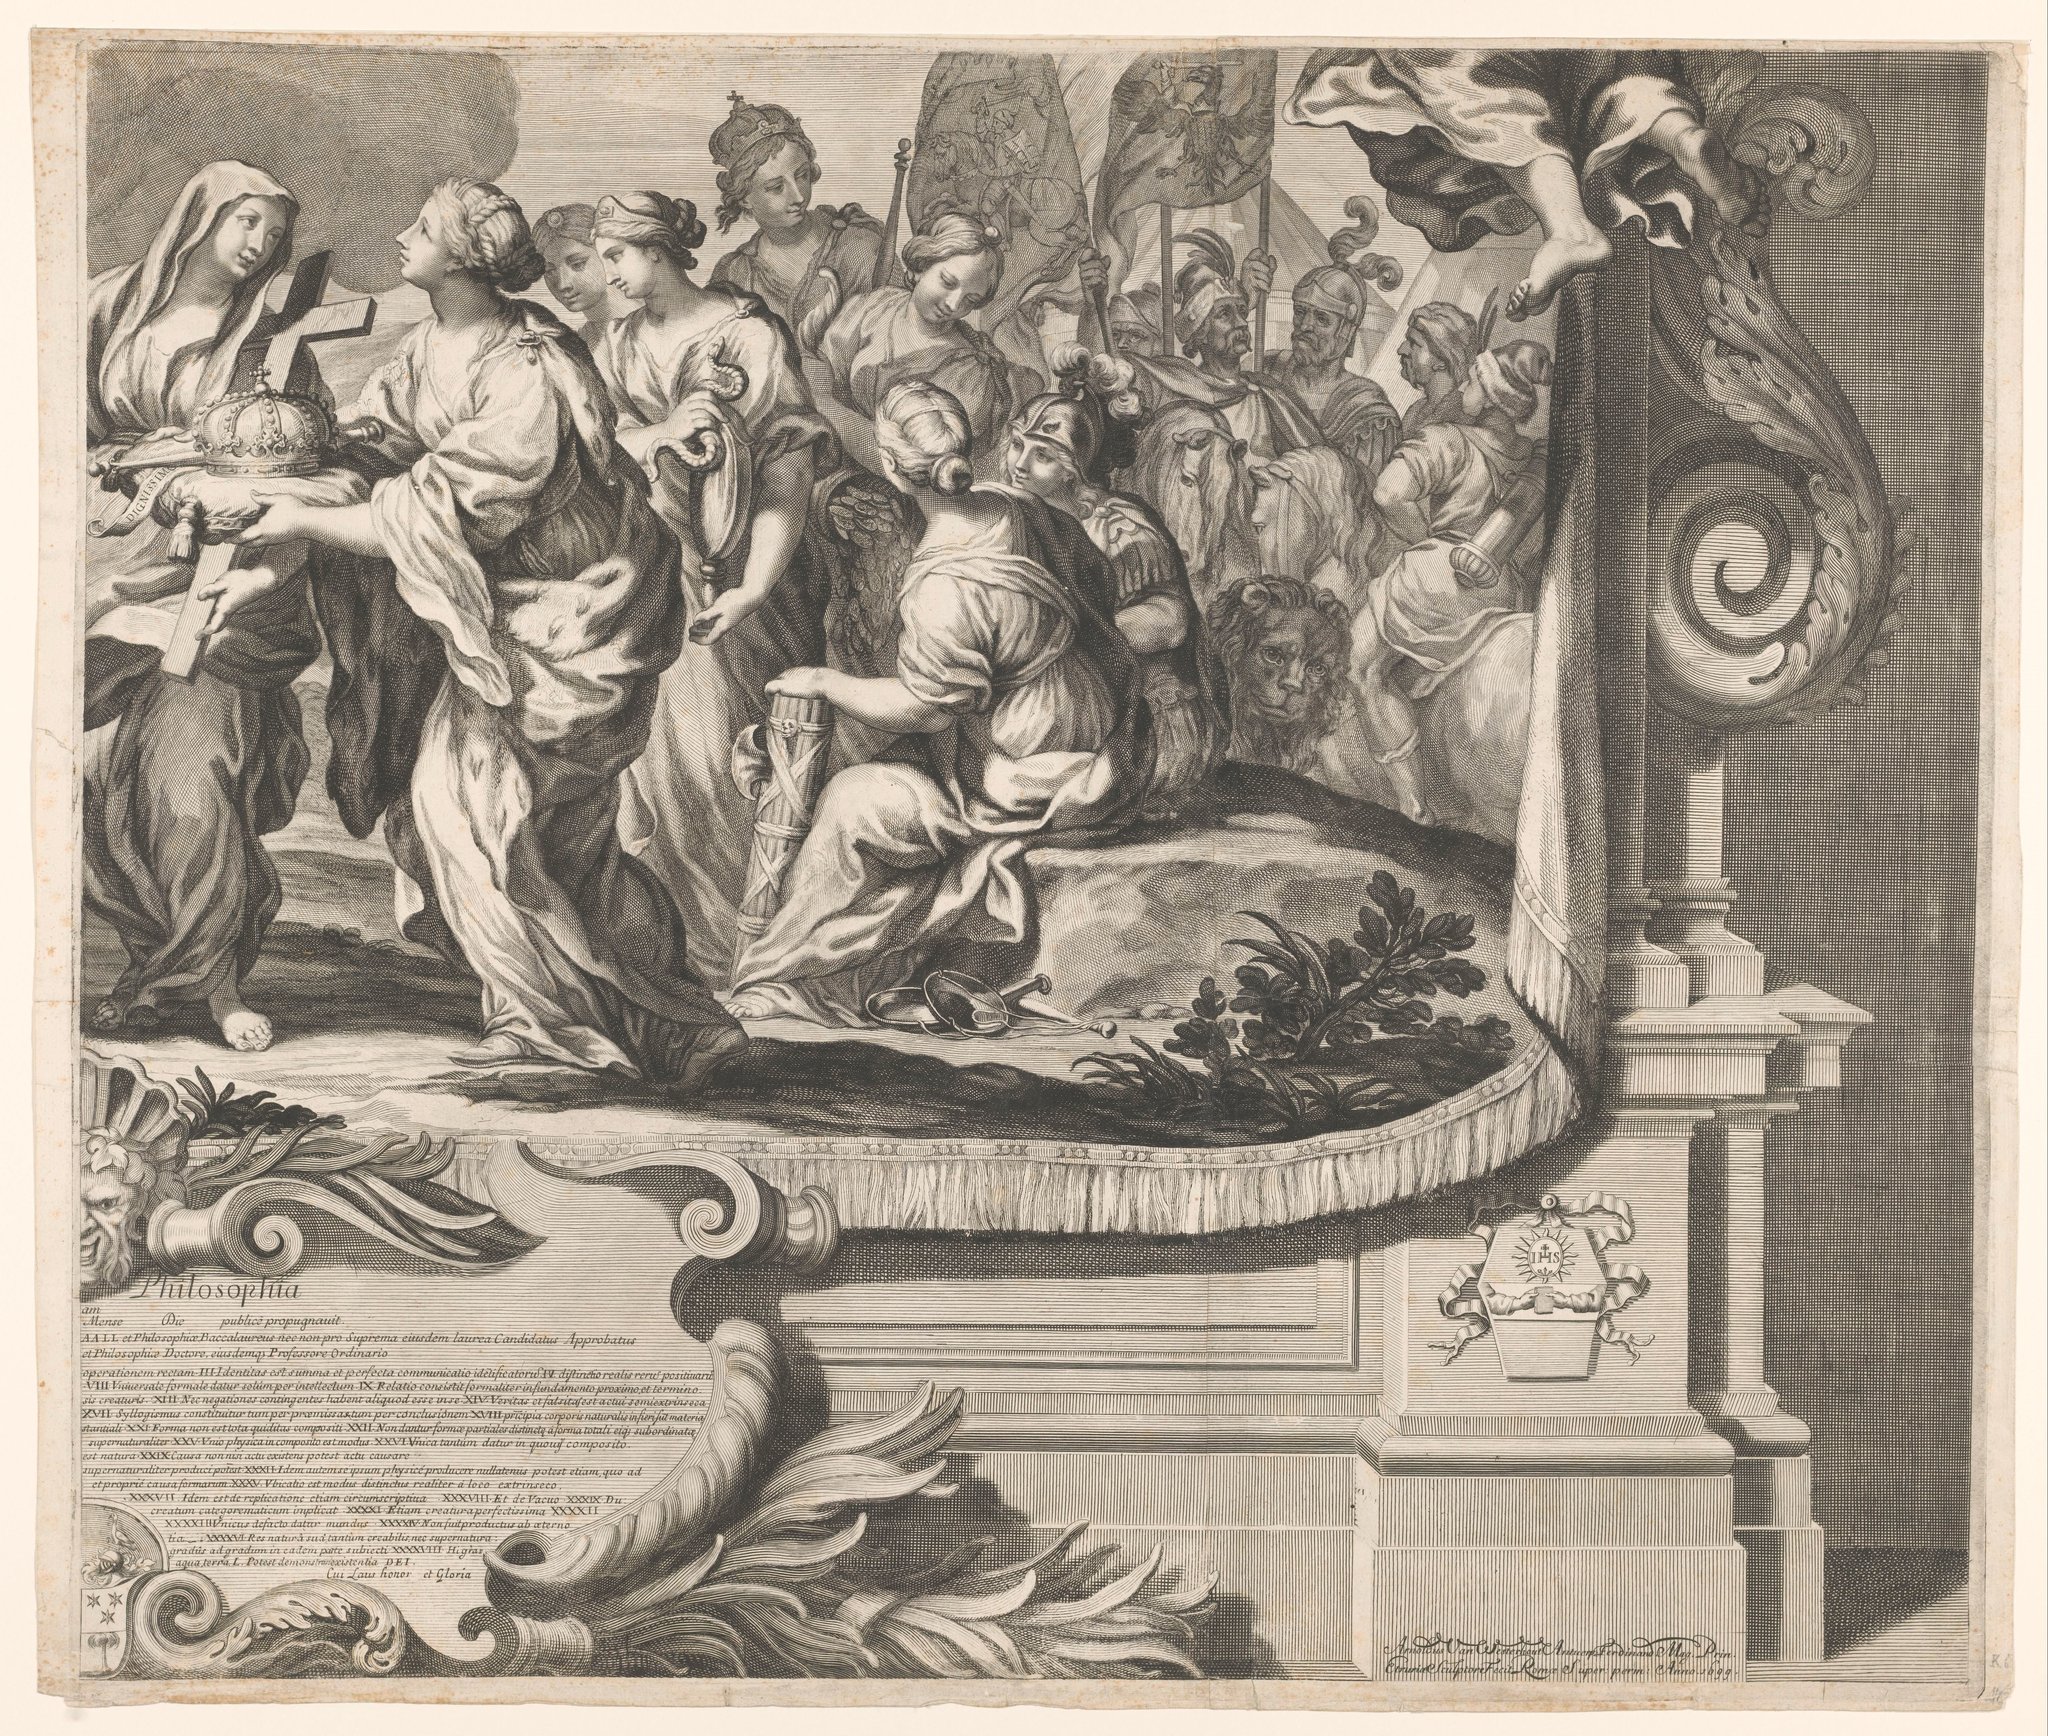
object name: print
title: Promotieprent voor Joannes Baptista a Pfeiffersberg (blad voor rechtsonder)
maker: arnold van westerhout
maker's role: print maker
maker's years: 1651-1725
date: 1699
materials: paper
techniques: engraving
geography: rome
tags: insignia and symbols of sovereignty (crown, diadem, sceptre, orb, seal, standard, cloak, pectoral)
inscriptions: collector's mark: Lugt 240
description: Deel van een processie waarin onder meer een kroon wordt overhandigd aan August II van Polen. In de ondermarge een negentienregelig vers in het Latijn ter gelegenheid van de promotie van Joannes Baptista a Pfeiffersberg.